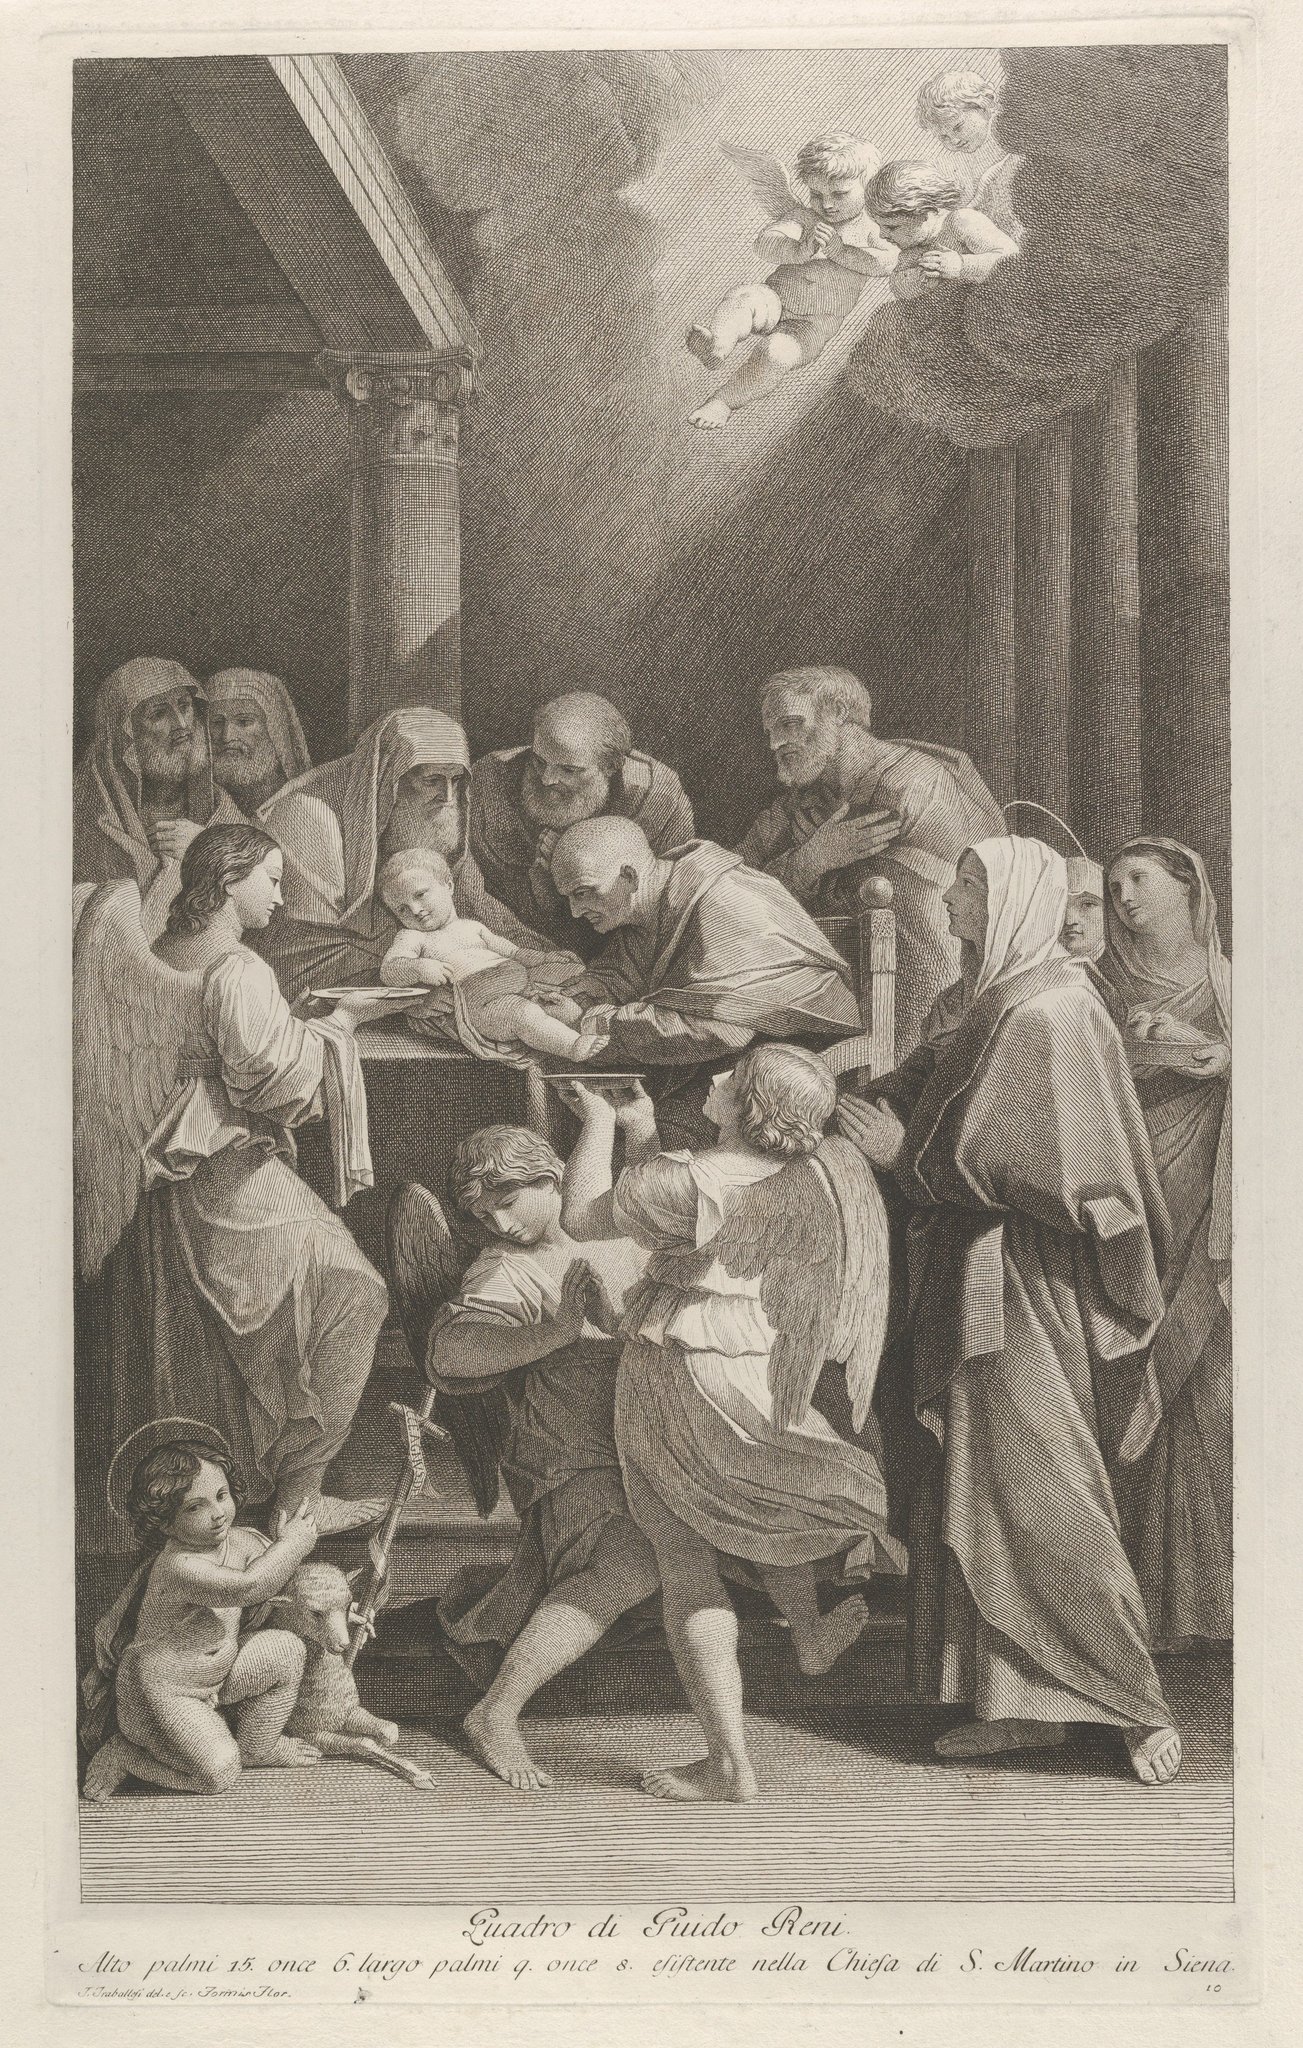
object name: print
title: The circumcision of Christ, a group of men, women and angels surrounding him, the young Saint John the Baptist at lower left, after Reni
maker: giuliano traballesi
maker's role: artist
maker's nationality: italian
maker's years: 1727-1812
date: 1760-1800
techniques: engraving, etching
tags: men,women,angels,saint john the baptist,circumcision